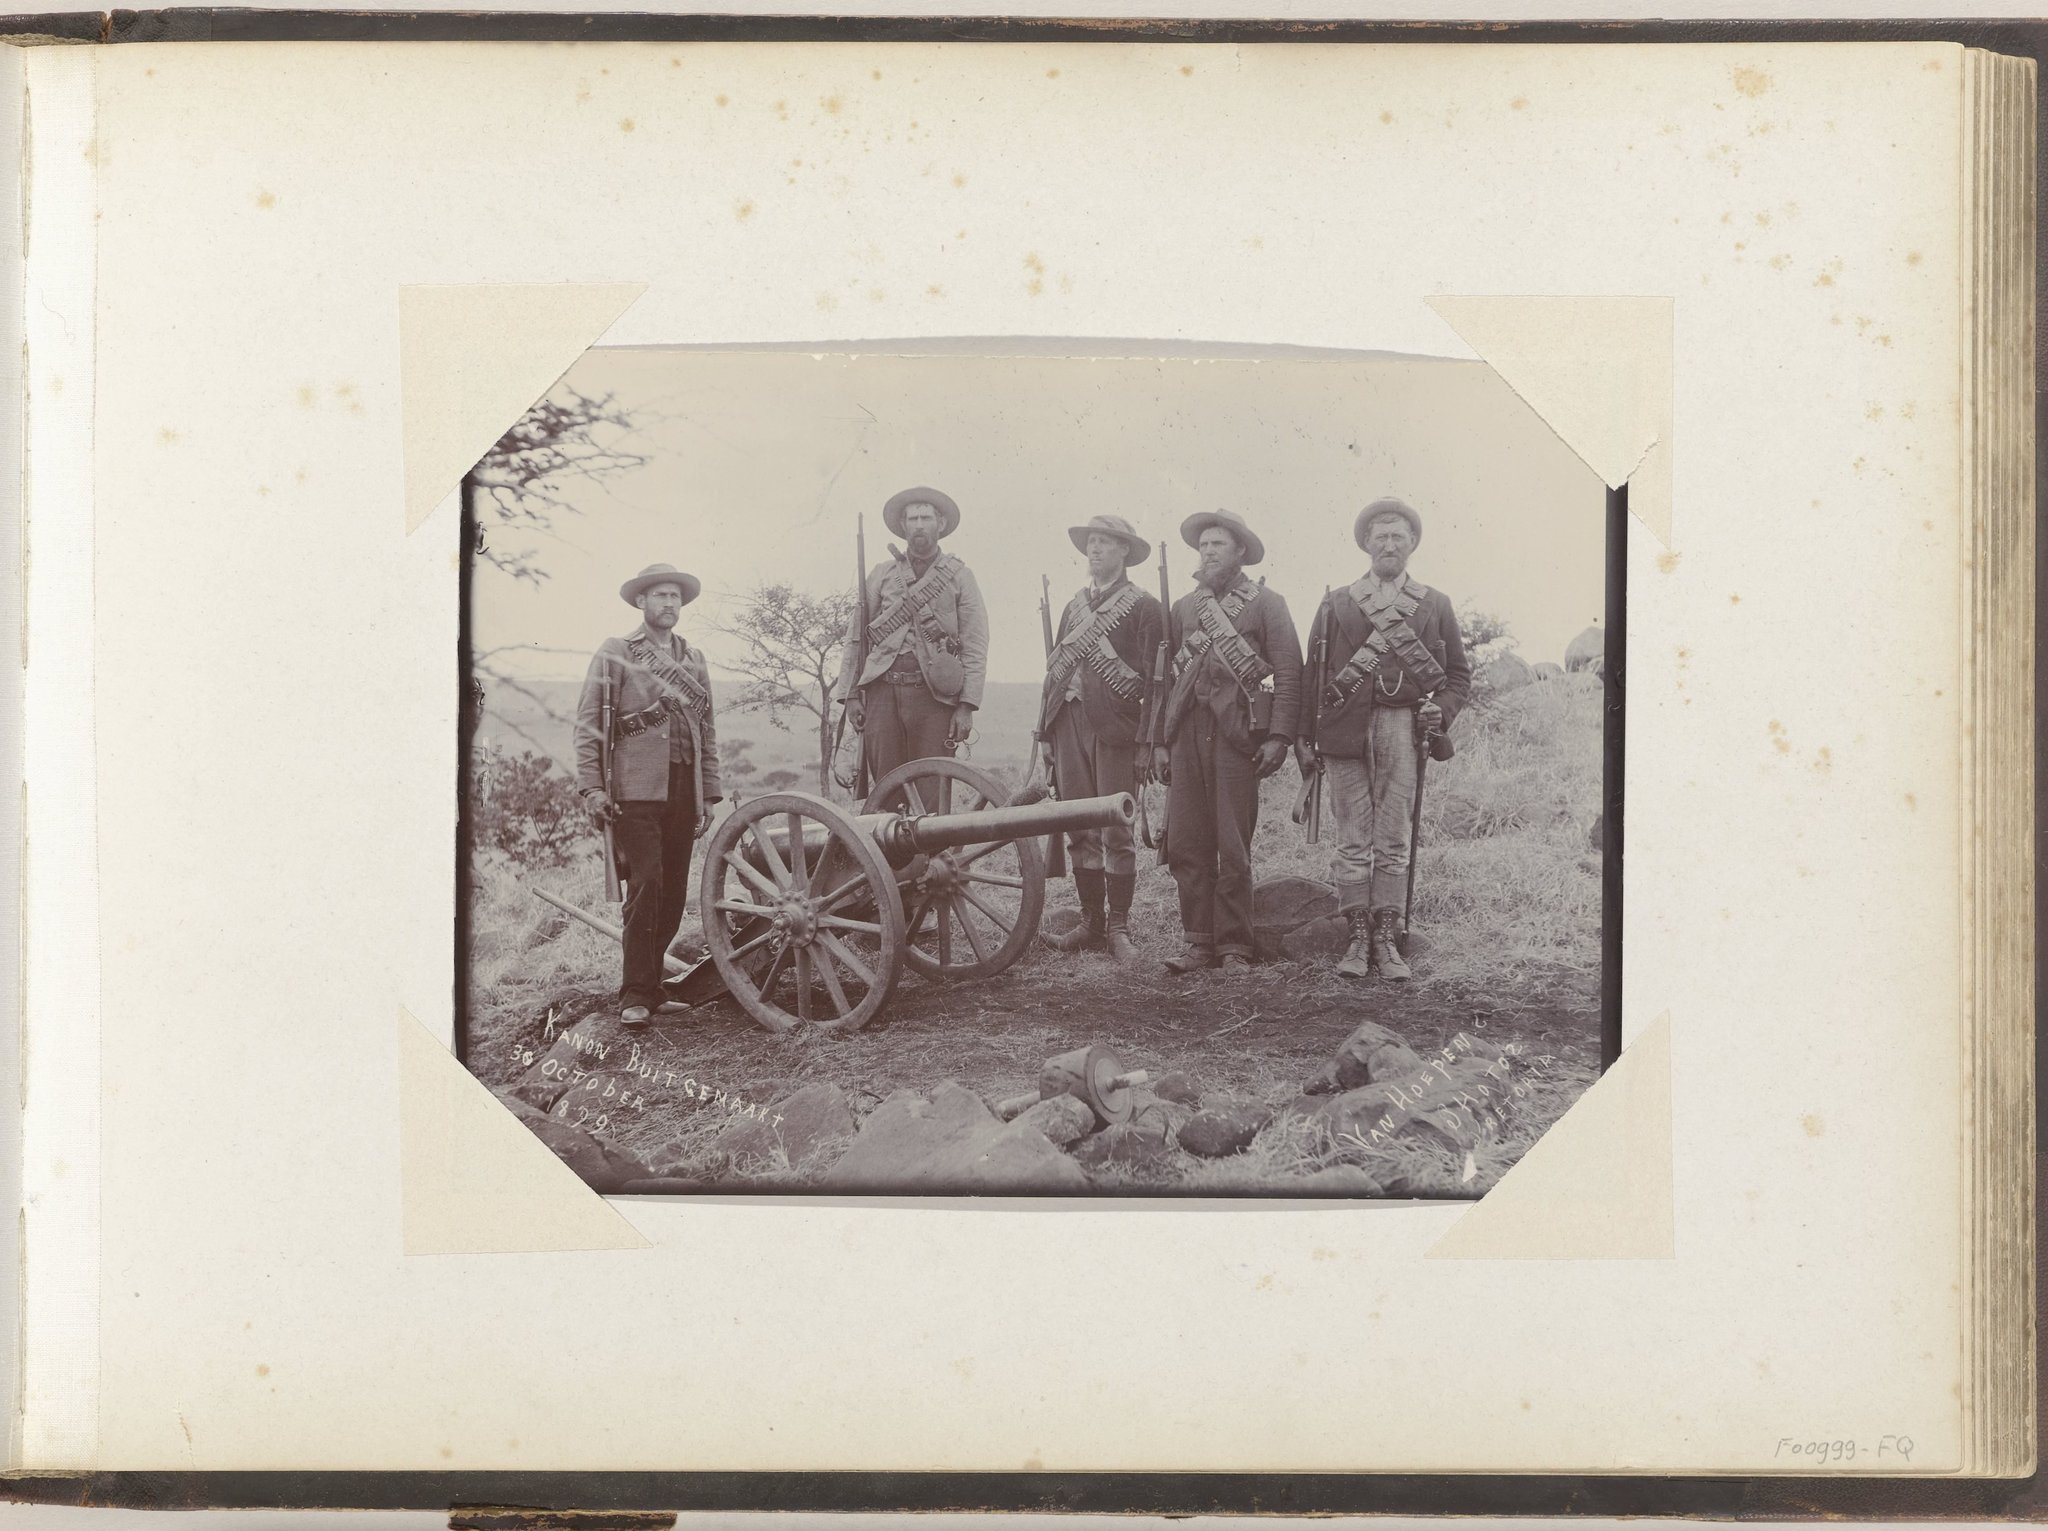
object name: photograph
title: Gewapende mannen bij een buitgemaakt kanon in Zuid-Afrika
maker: jan van hoepen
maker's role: fotograaf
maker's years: 1856-1922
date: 1899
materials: paper, photographic support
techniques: gelatin silver print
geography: south africa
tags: firearms: cannon (+ land forces)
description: Onderdeel van Album met 191 foto's van een reis naar en door Zuid-Afrika.